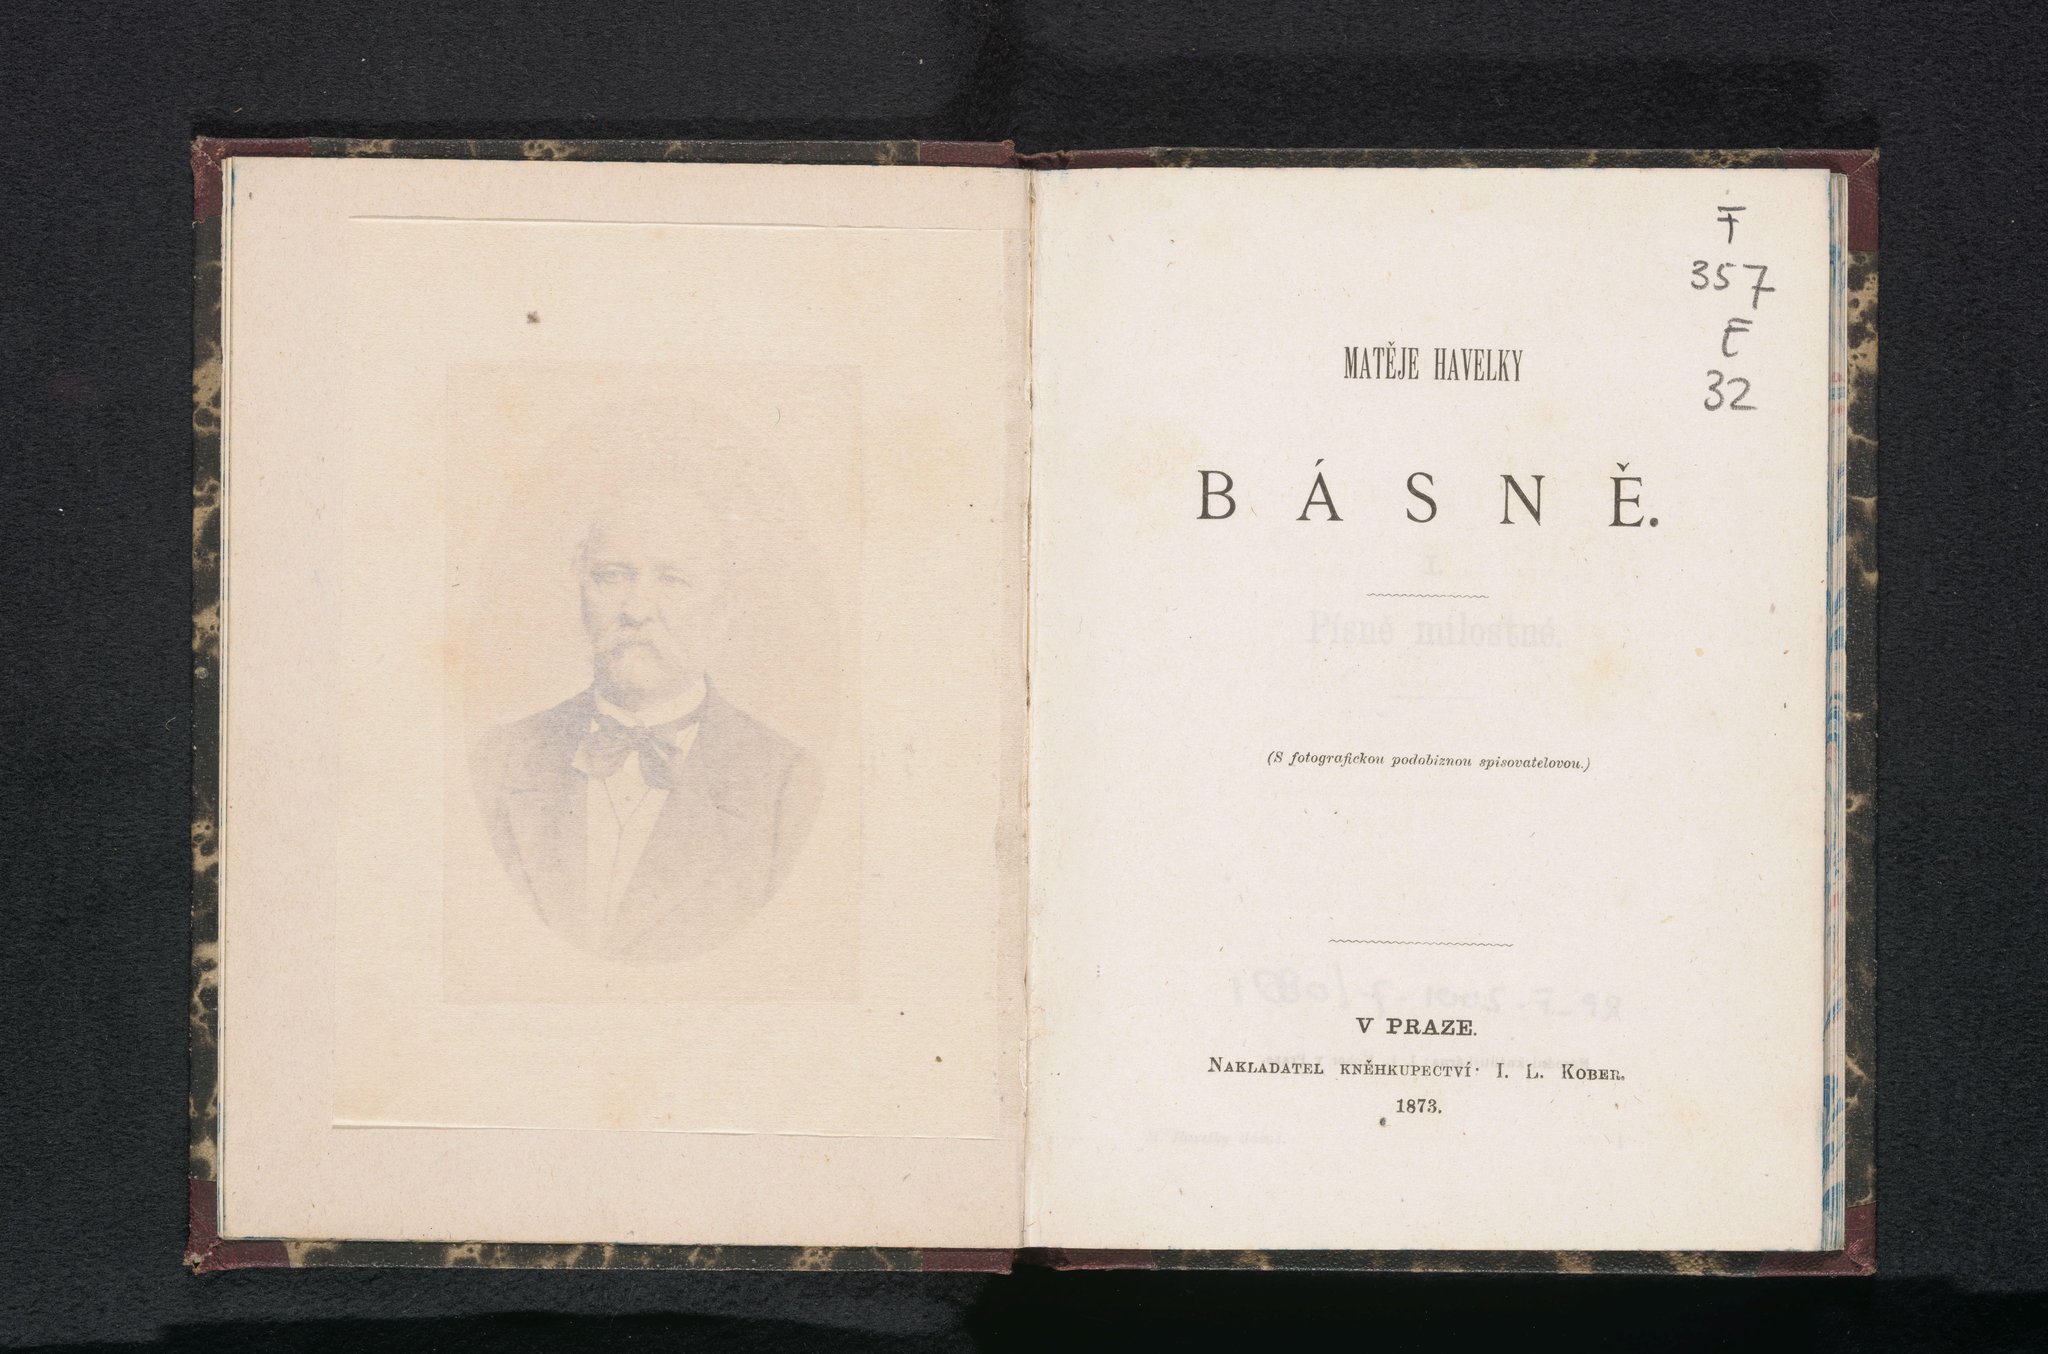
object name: book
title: Básně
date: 1873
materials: cardboard, linen, paper, photographic support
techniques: marbled paper, albumen print, printing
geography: prague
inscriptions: inscription: ‘L. Gru[...]’